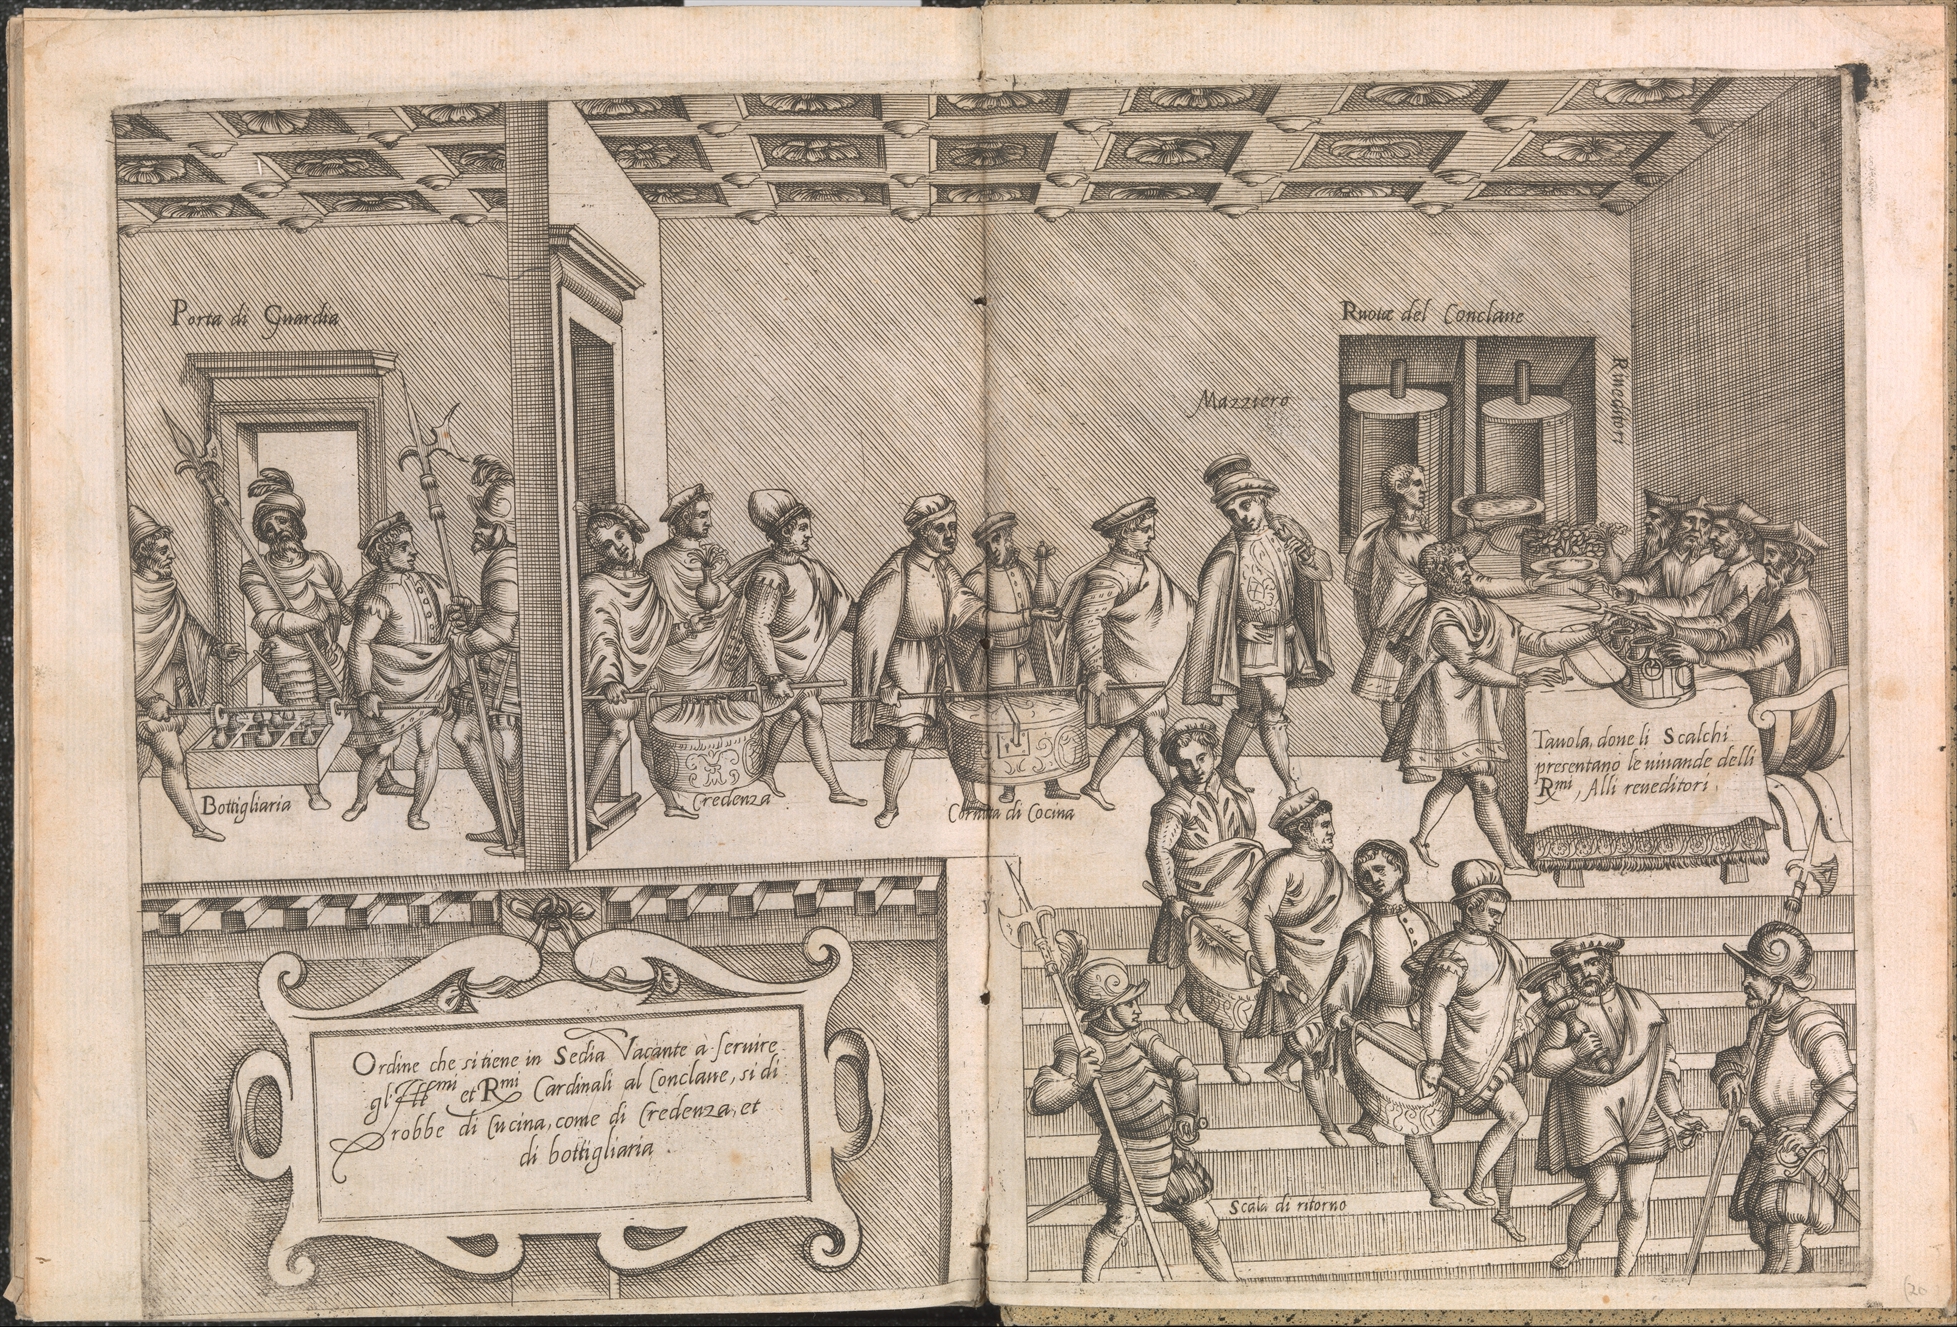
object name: book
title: Opera di M. Bartolomeo Scappi, cuoco secreto di Papa Pio V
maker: bartolomeo scappi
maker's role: author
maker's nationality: italian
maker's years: 1495-1577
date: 1570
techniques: engraving, printing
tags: kitchens,men